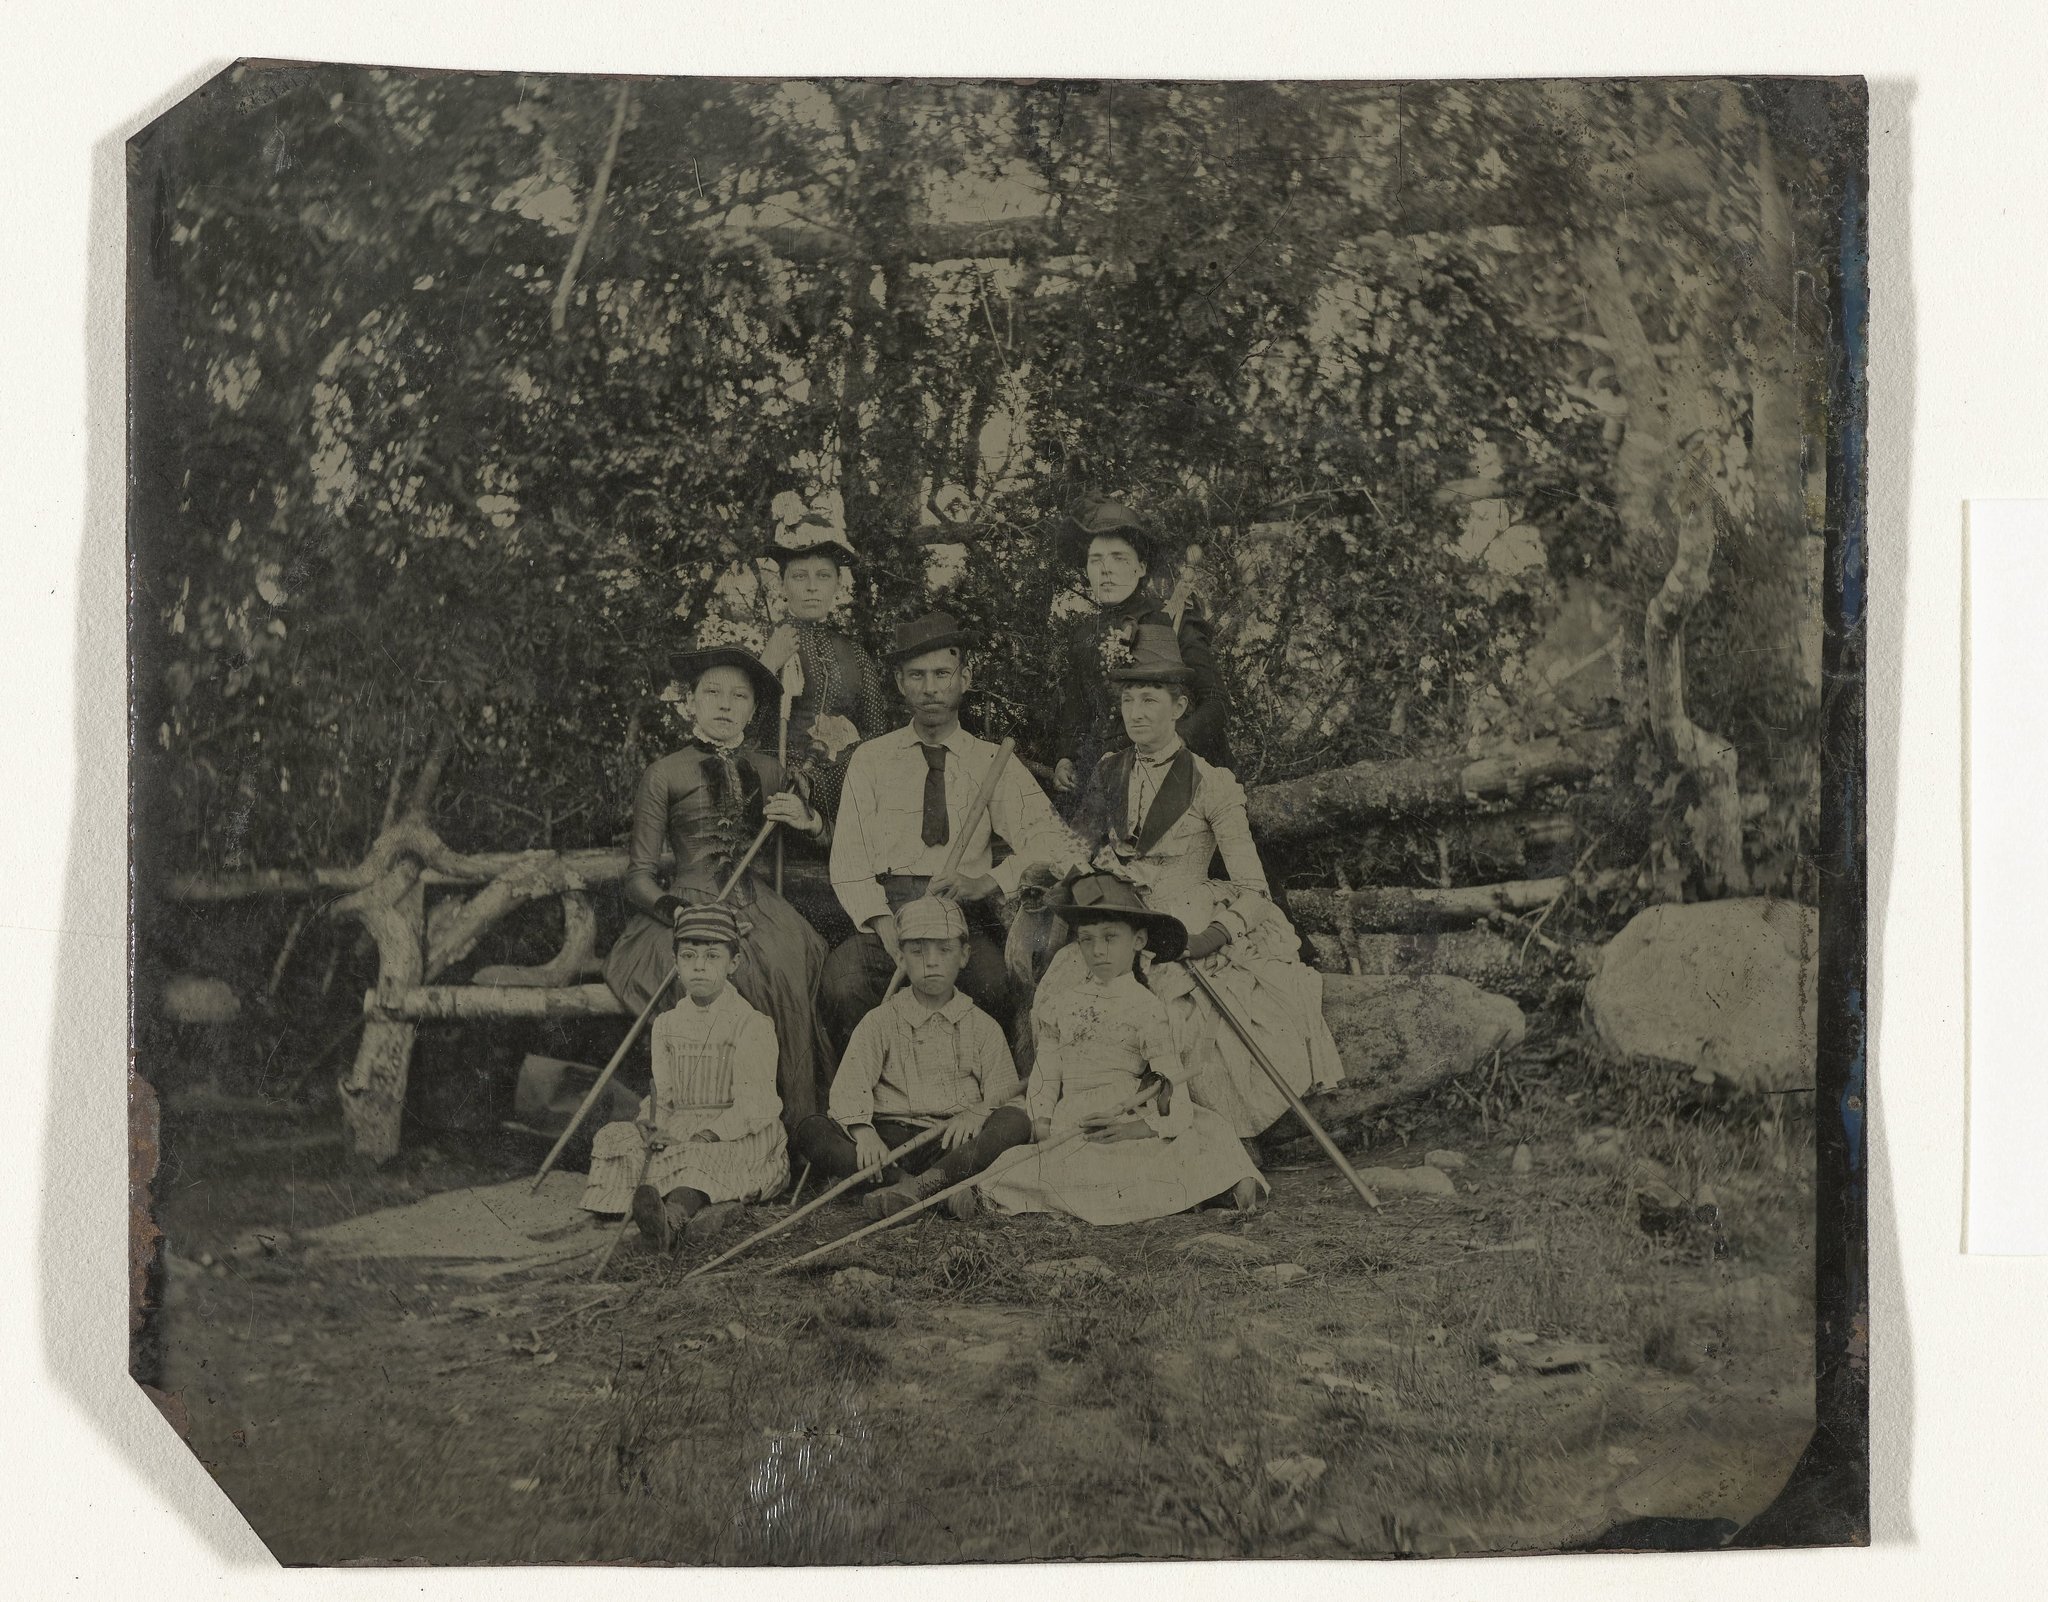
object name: photograph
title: Groepsportret van een man, vier vrouwen, een jongen en twee meisjes, staand en zittend in een landschap (Adirondacks, Verenigde Staten?), met wandelstokken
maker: Anonymous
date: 1870-1900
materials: metal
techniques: ferrotyping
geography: united states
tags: adirondack mountains